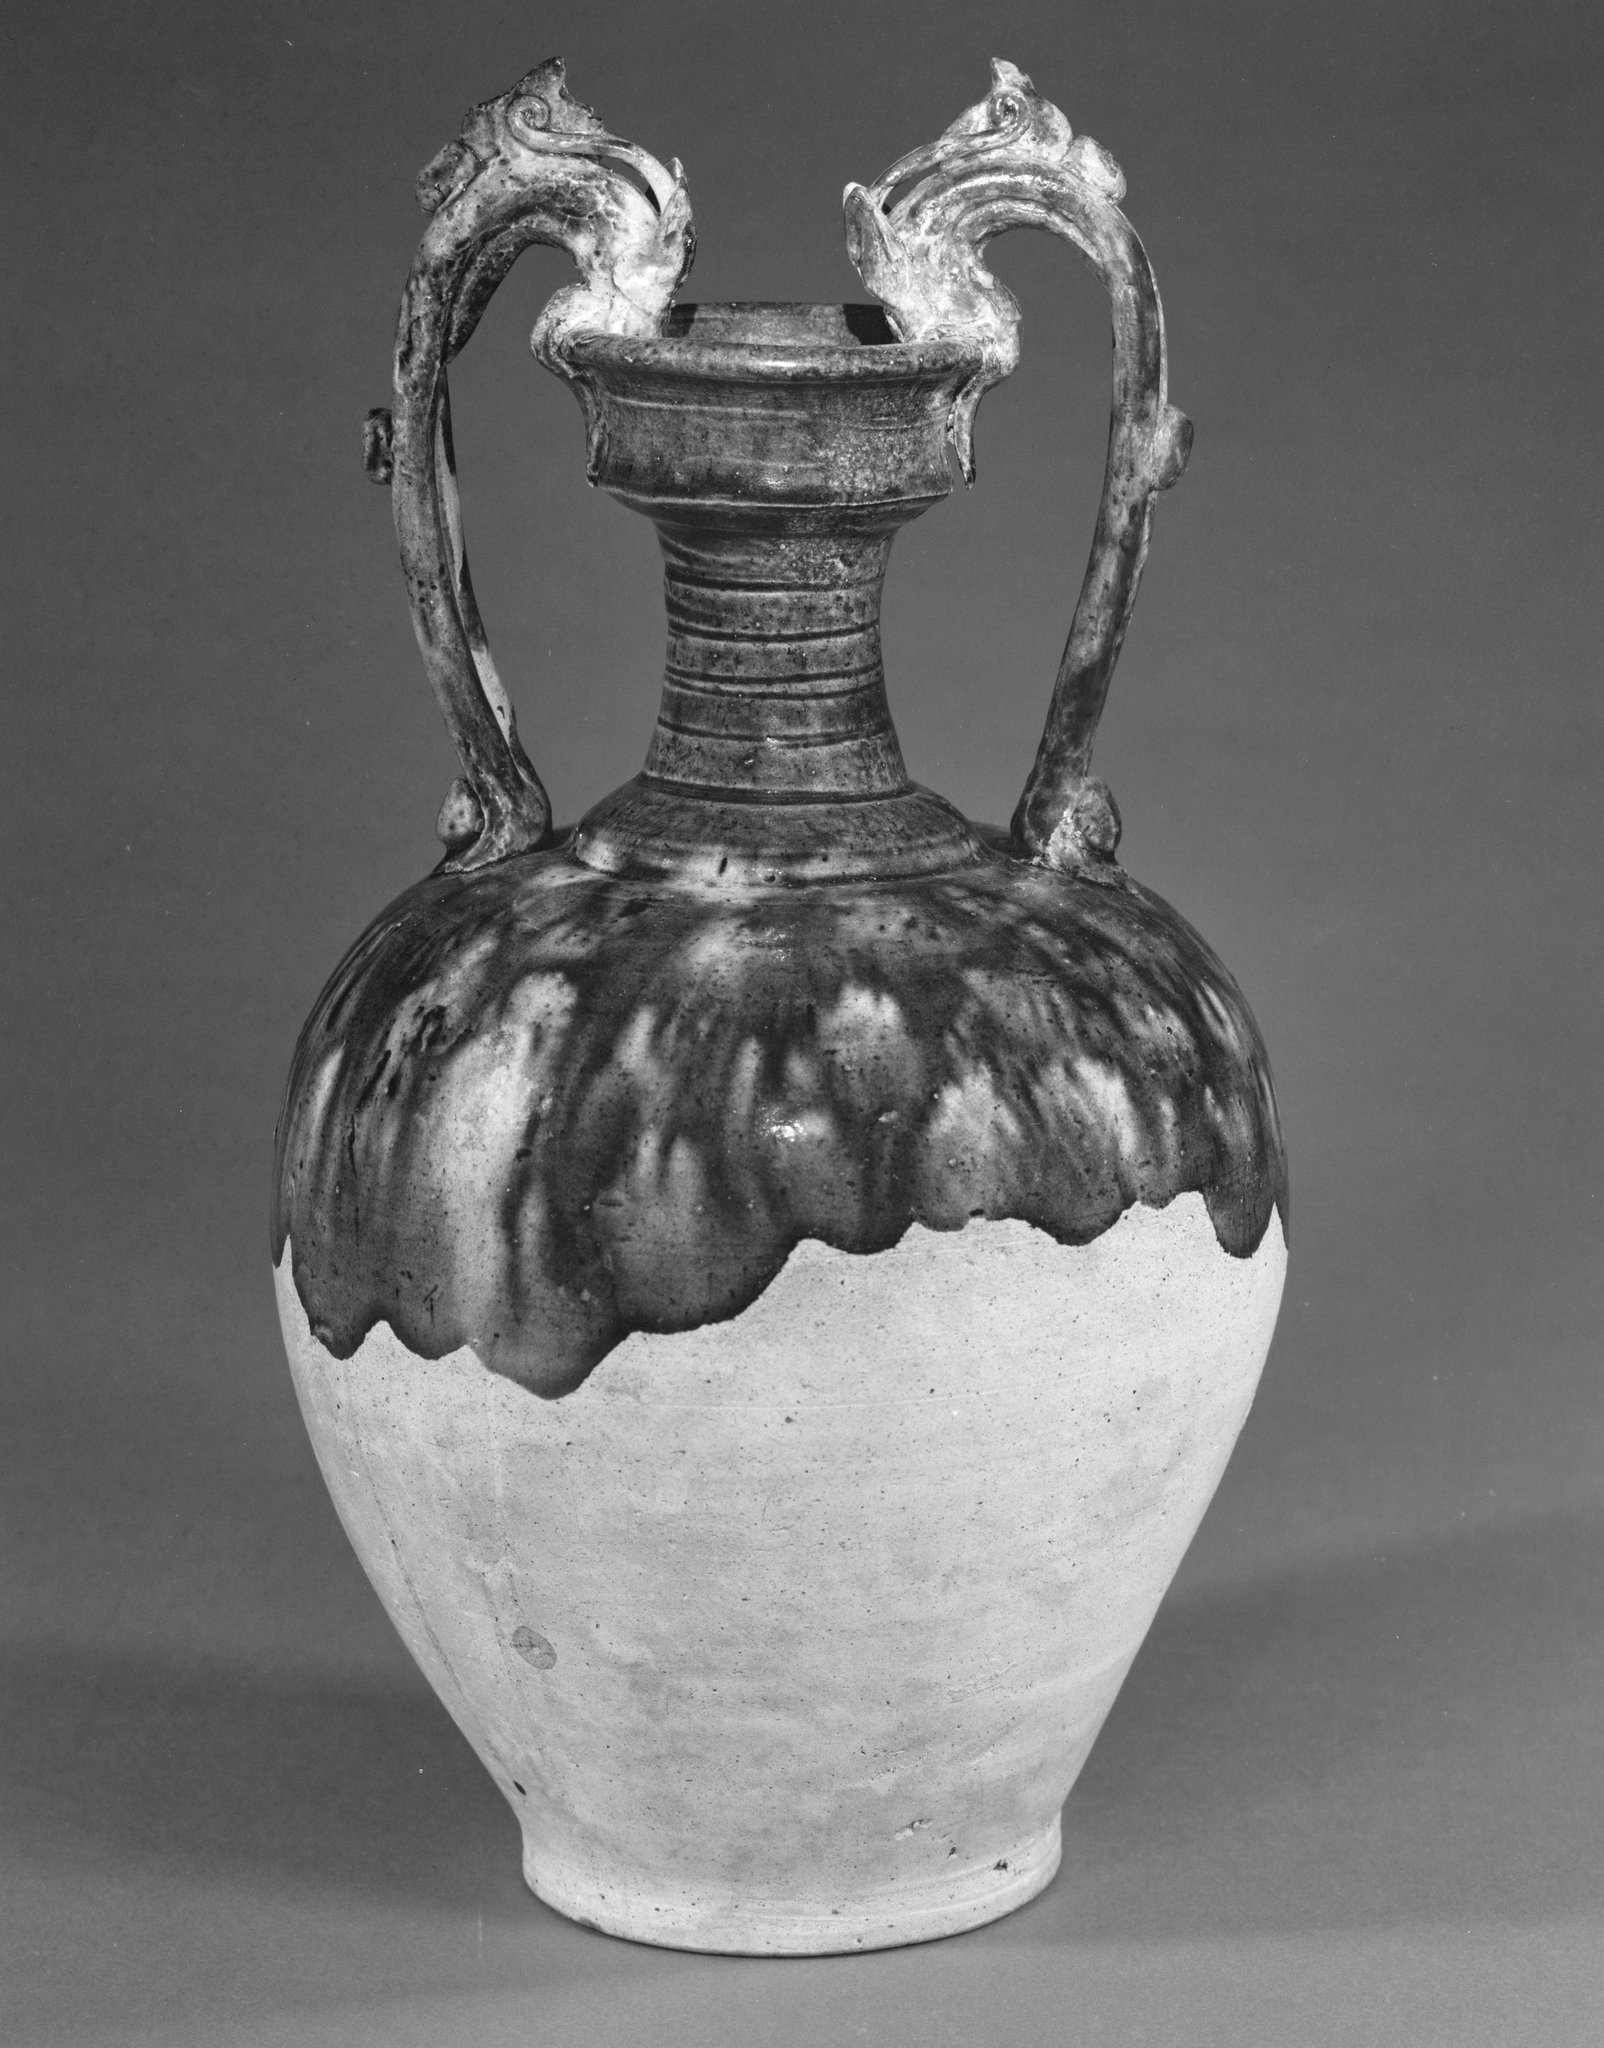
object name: amphora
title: Amphora with dragon-shaped handles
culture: chinese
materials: earthenware, glaze